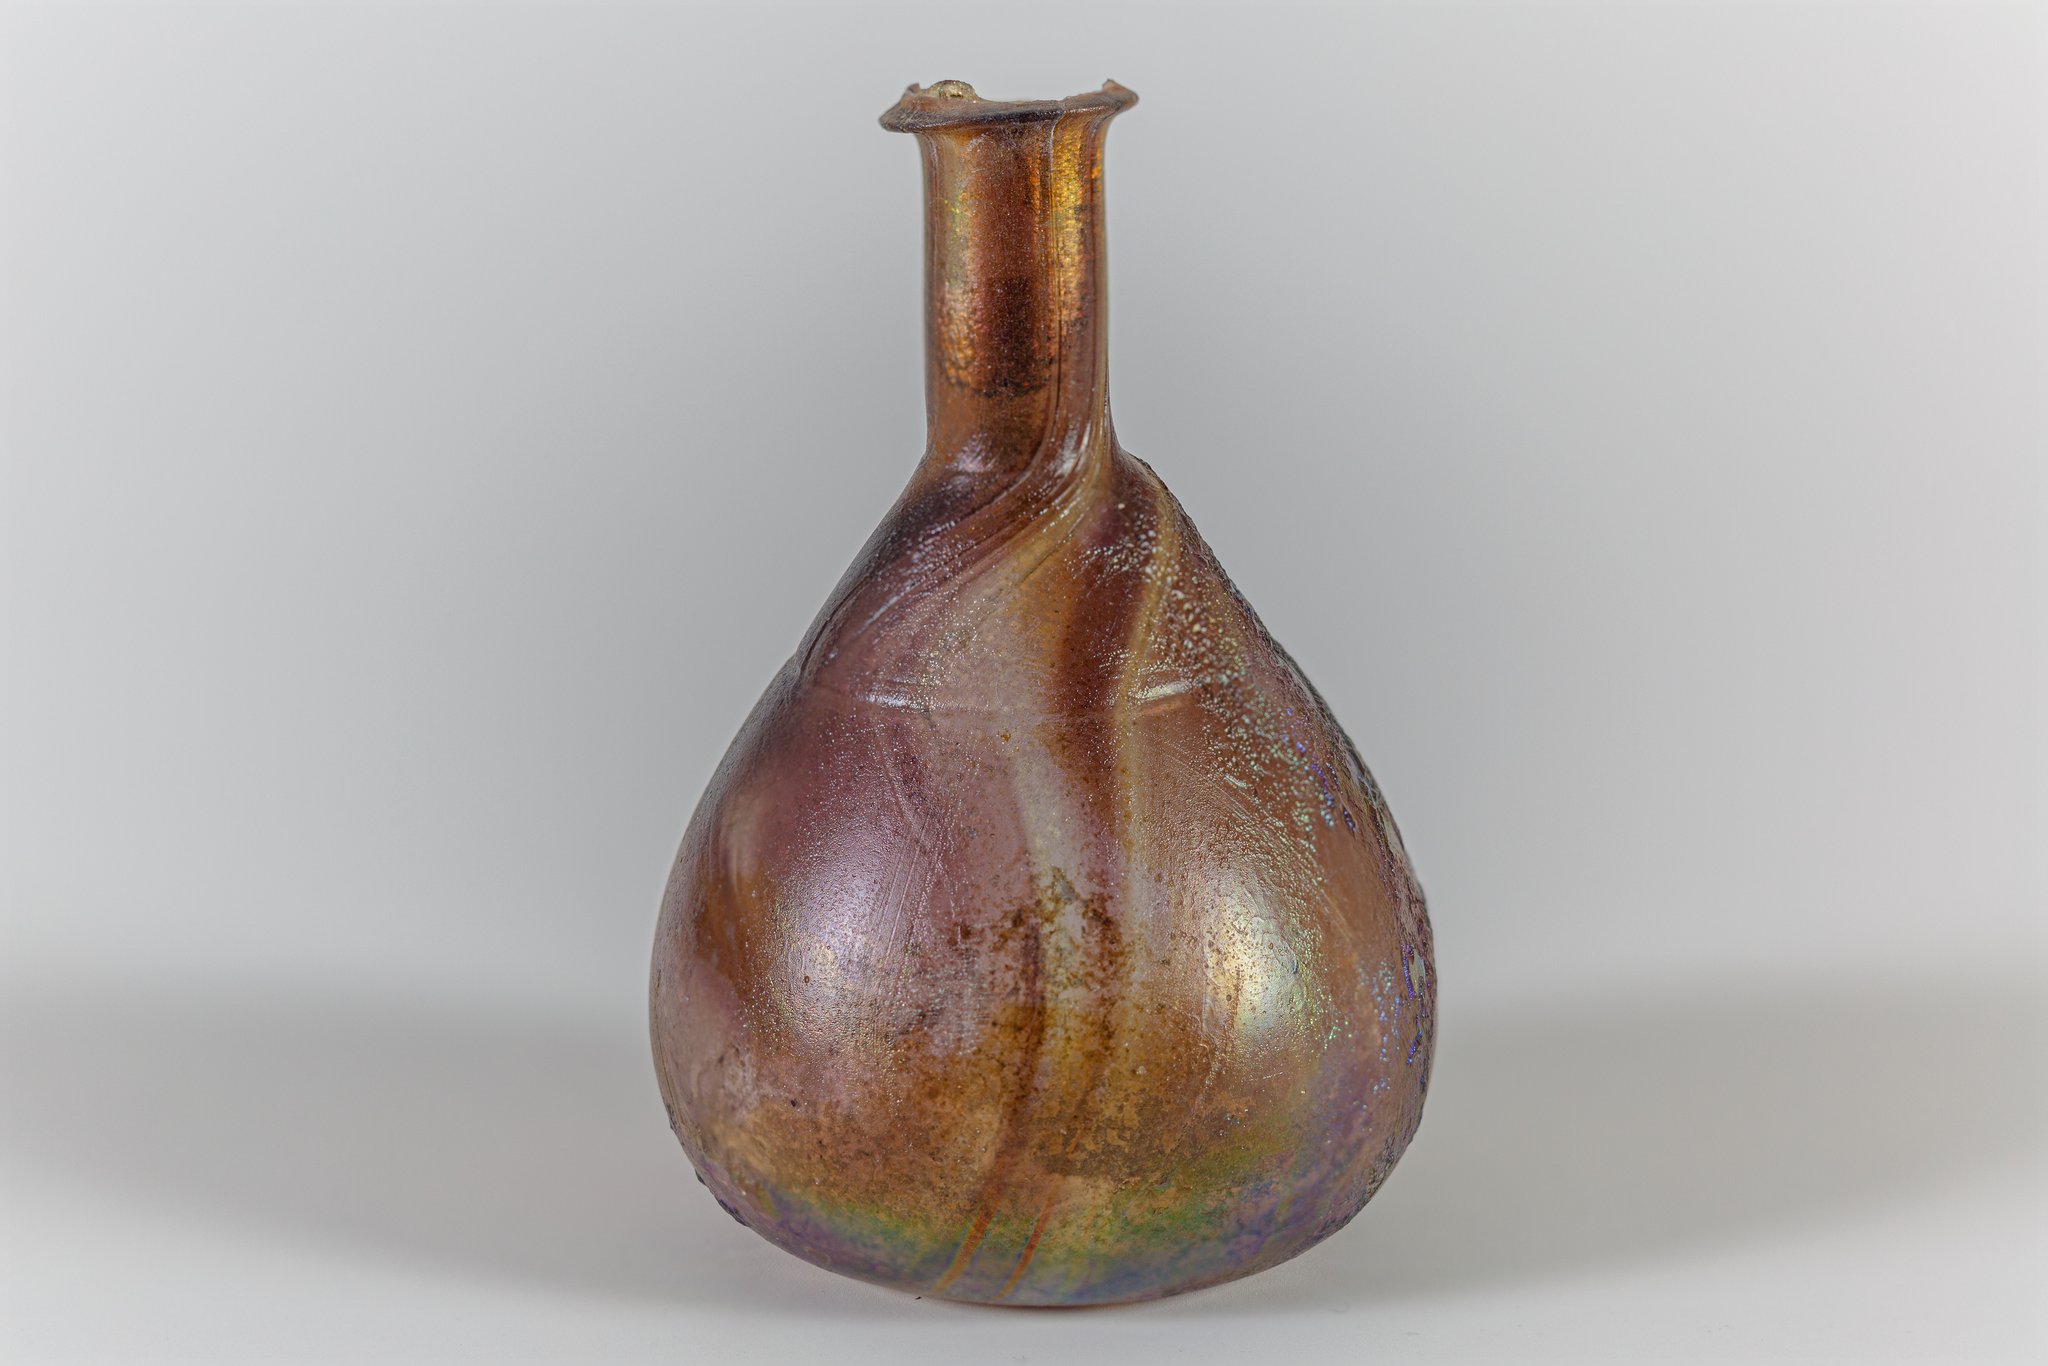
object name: perfume bottle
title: Glass perfume bottle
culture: roman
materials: glass